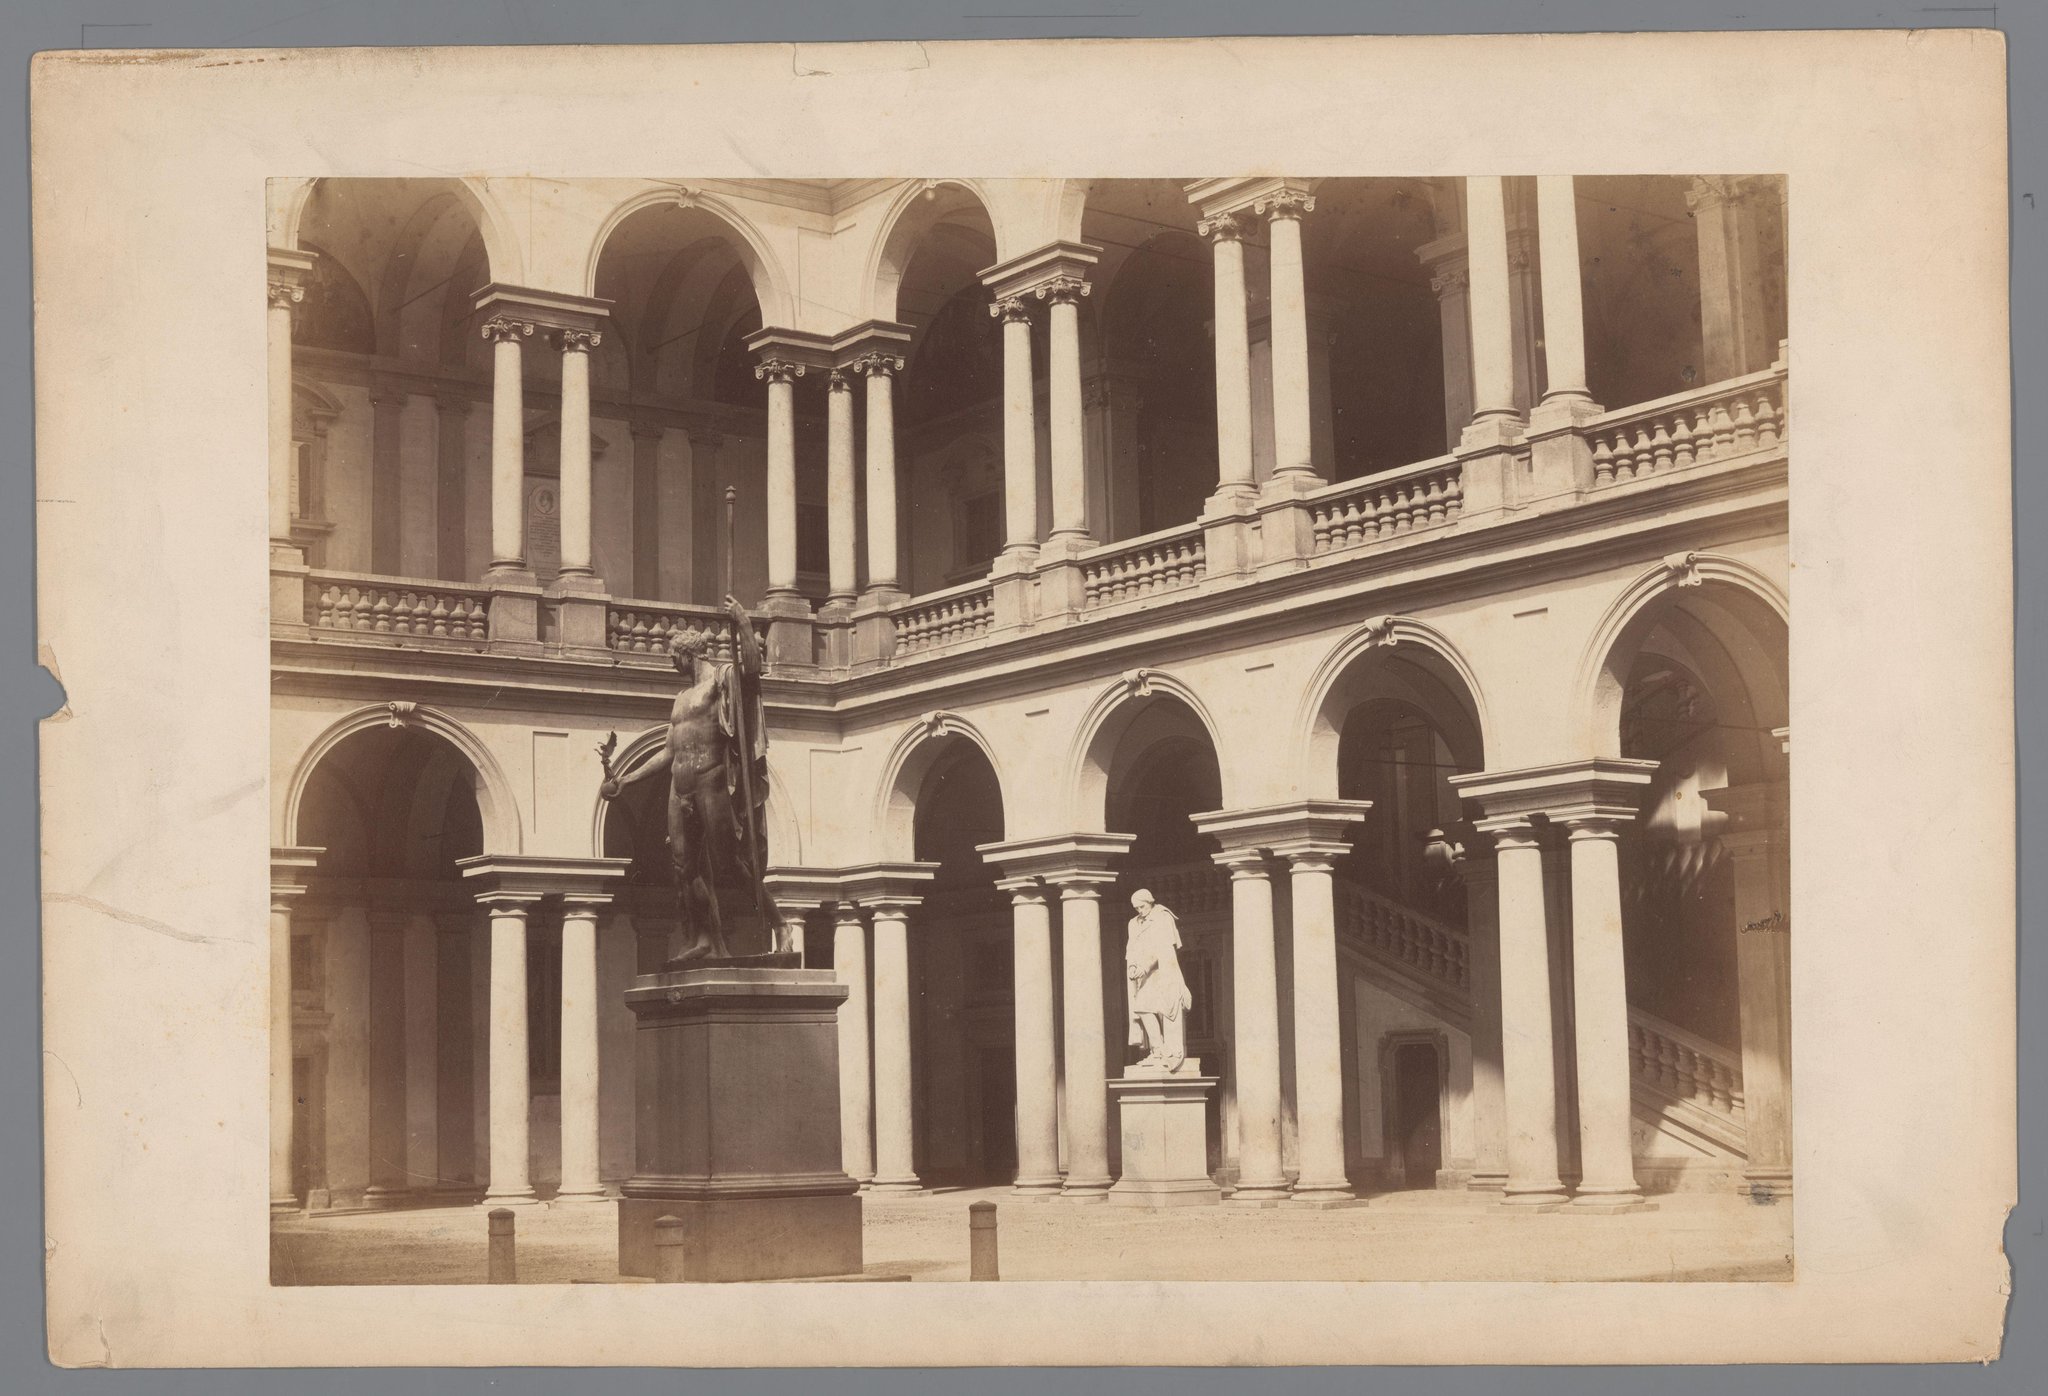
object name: photograph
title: Binnenplaats met twee standbeelden van een gebouw met op twee verdiepingen een zuilengalerij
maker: Anonymous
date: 1875-1900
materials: cardboard, photographic support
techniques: albumen print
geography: europe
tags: colonnade, monument, statue, courtyard, europe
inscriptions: collector's mark: Lugt 3937